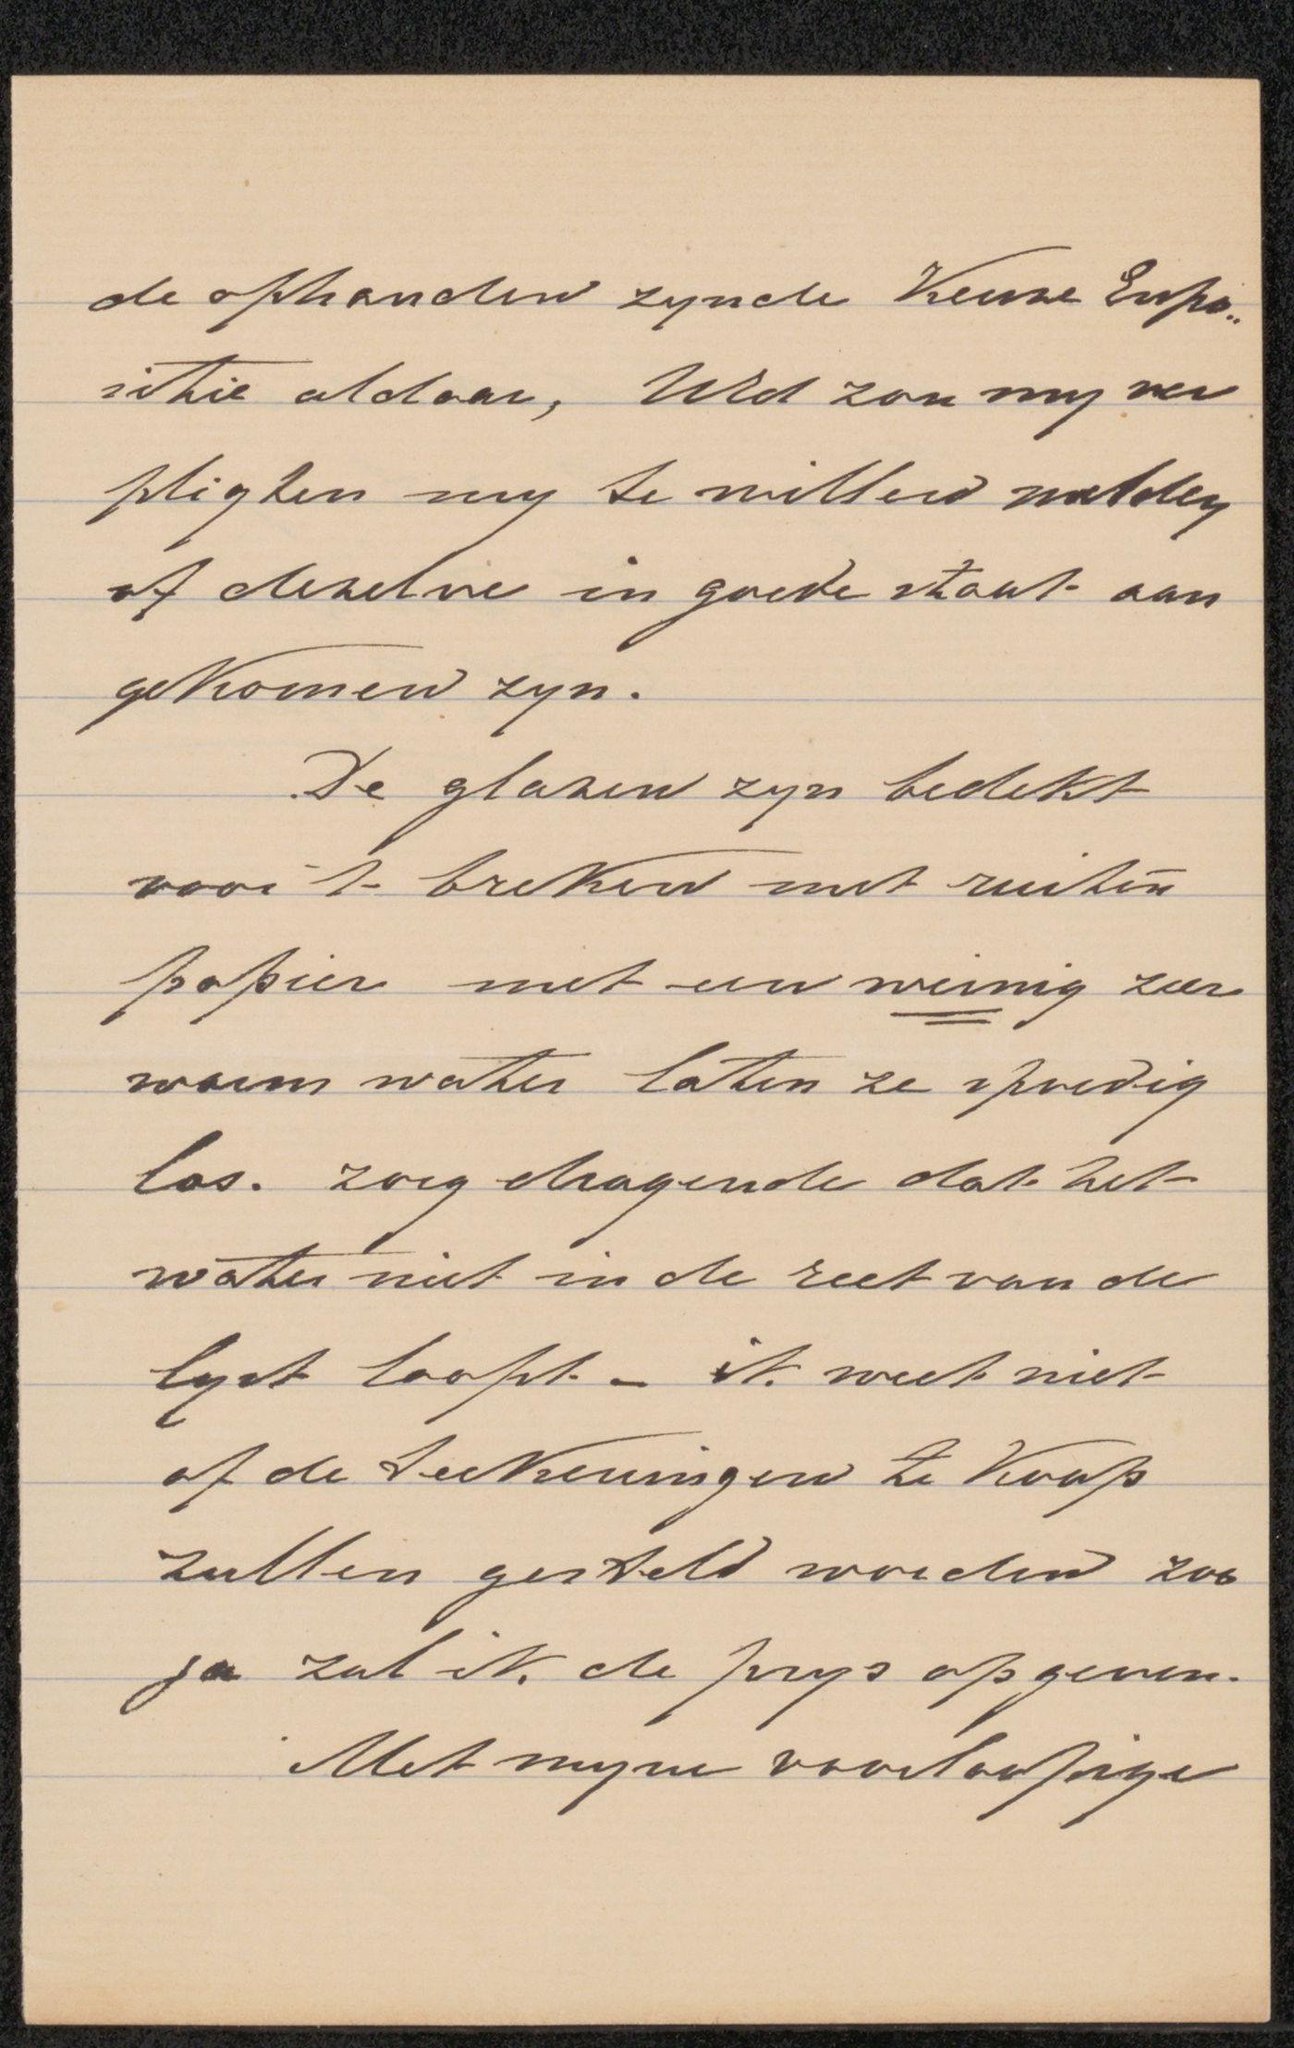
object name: letter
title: Brief aan G.M. Slothouwer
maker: paul joseph constantin gabriël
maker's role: draughtsman, print maker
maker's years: 1828-1903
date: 1896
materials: ink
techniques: pen, writing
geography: scheveningen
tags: drawing, exhibition ~ art, money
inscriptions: collector's mark: ‘RPK’